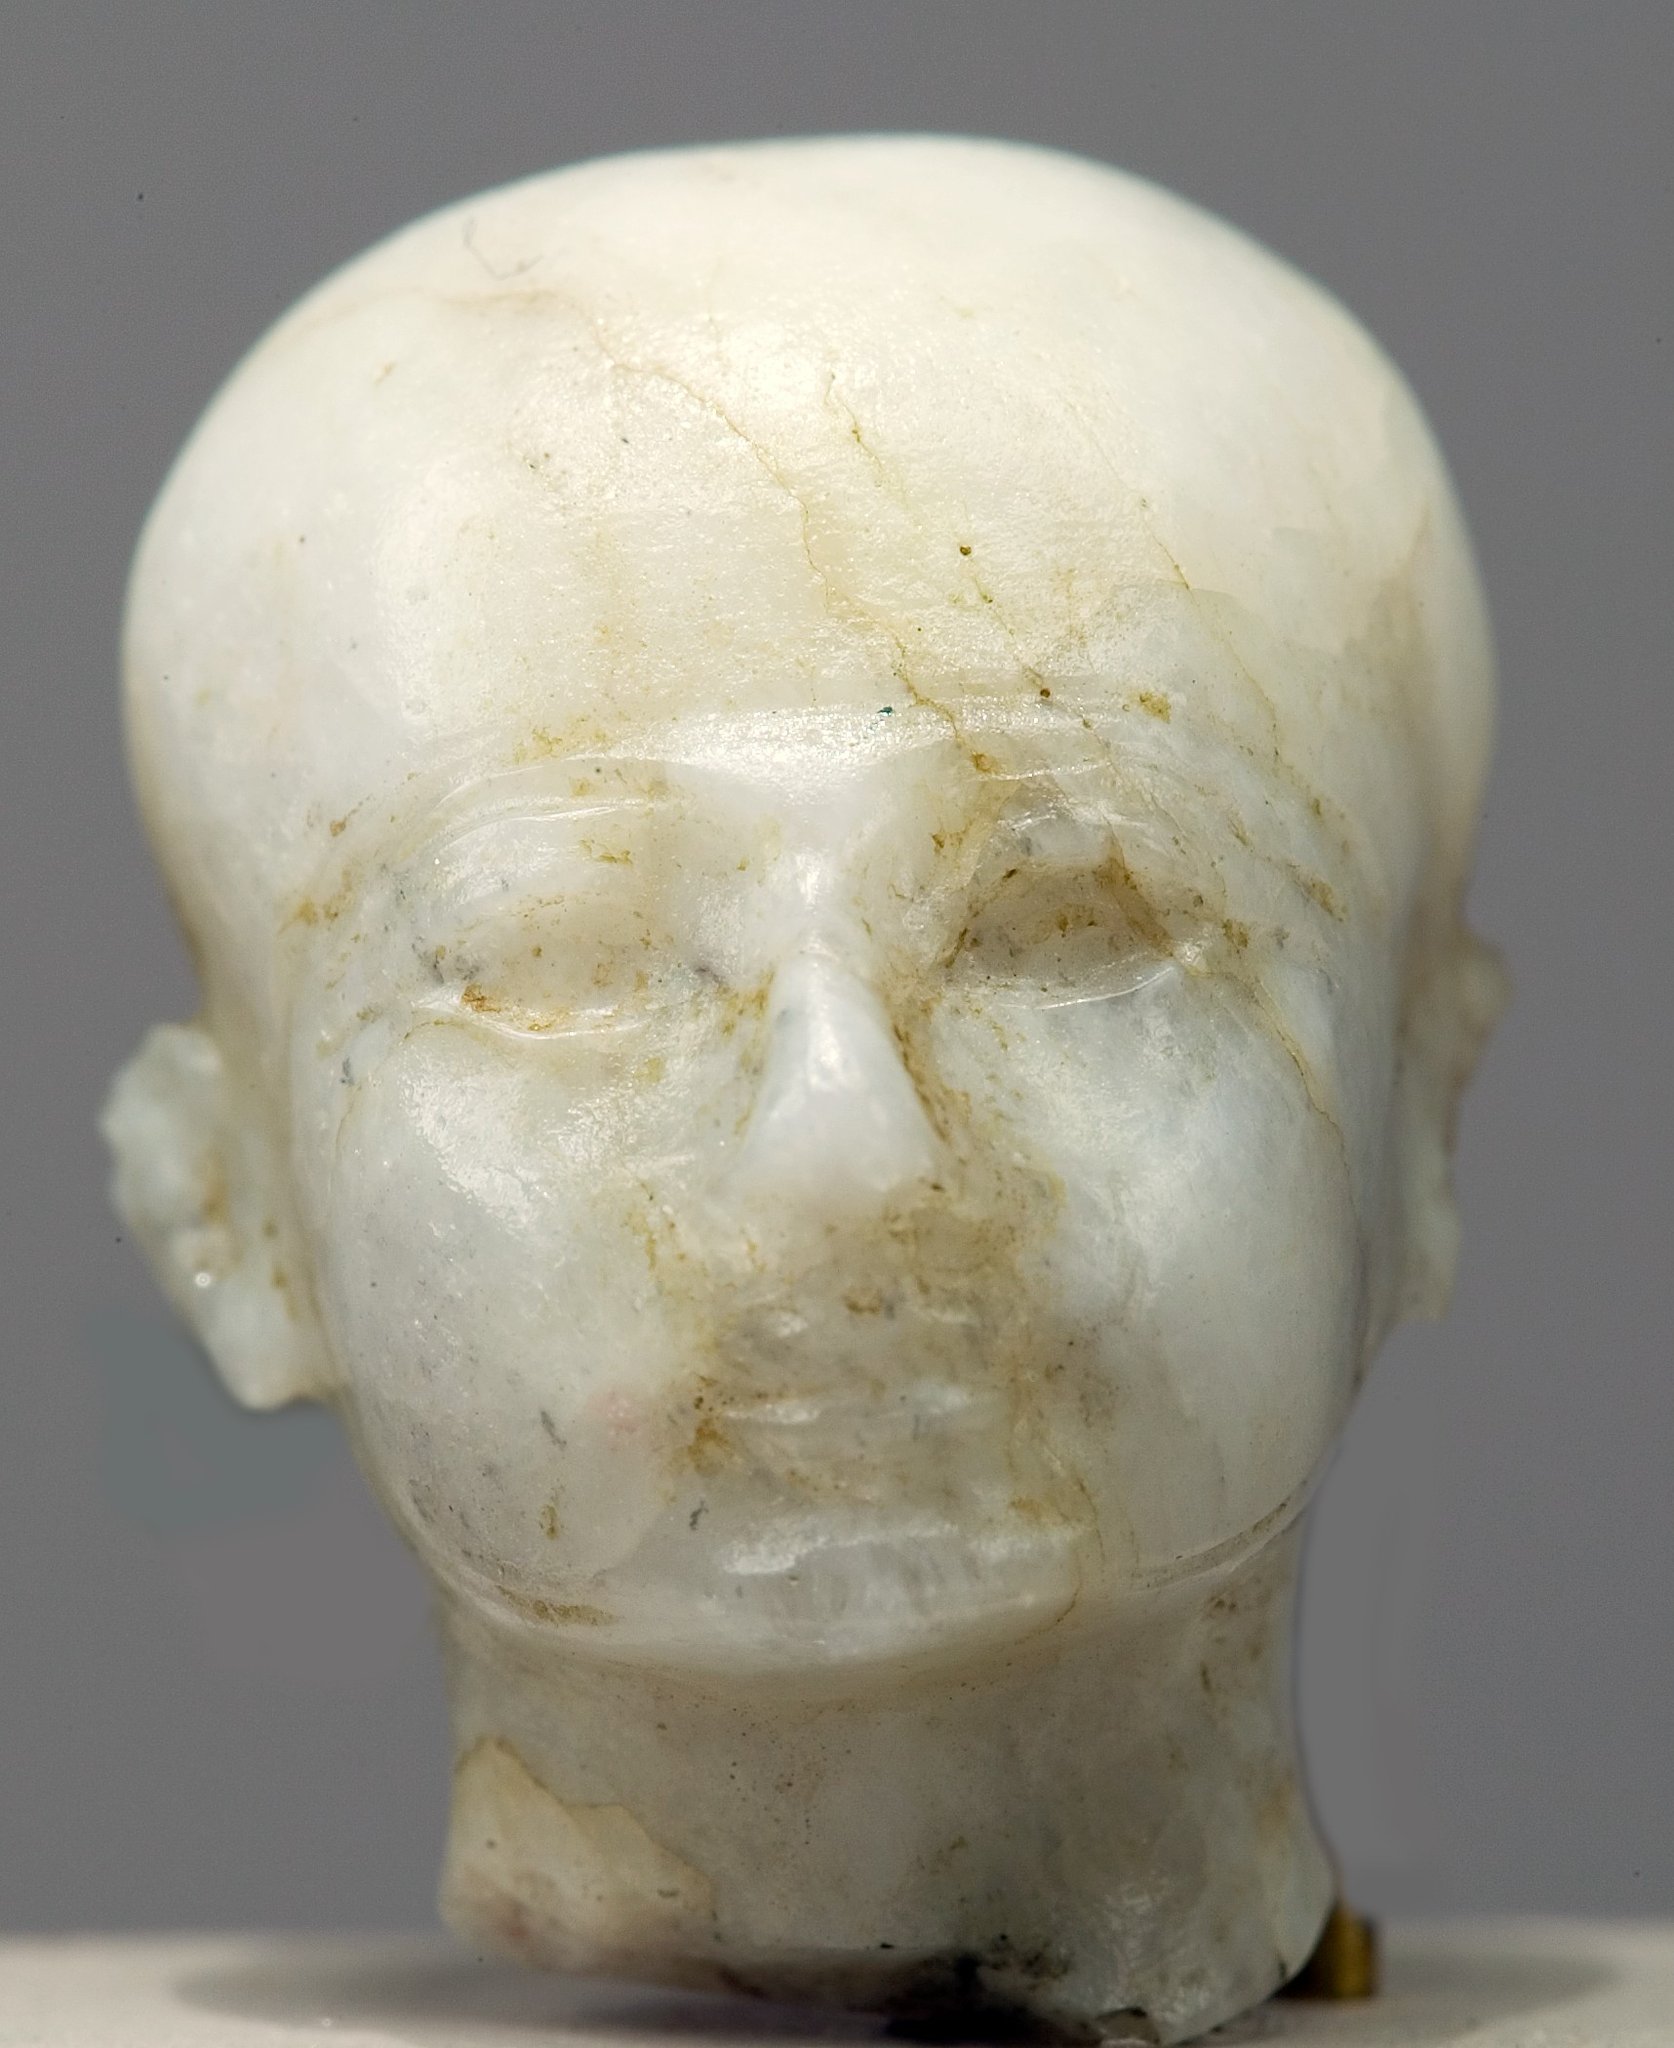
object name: head,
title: Head with cap and beardstraps, perhaps Ptah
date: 1295-1070 BCE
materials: quartz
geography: egypt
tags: heads,horus